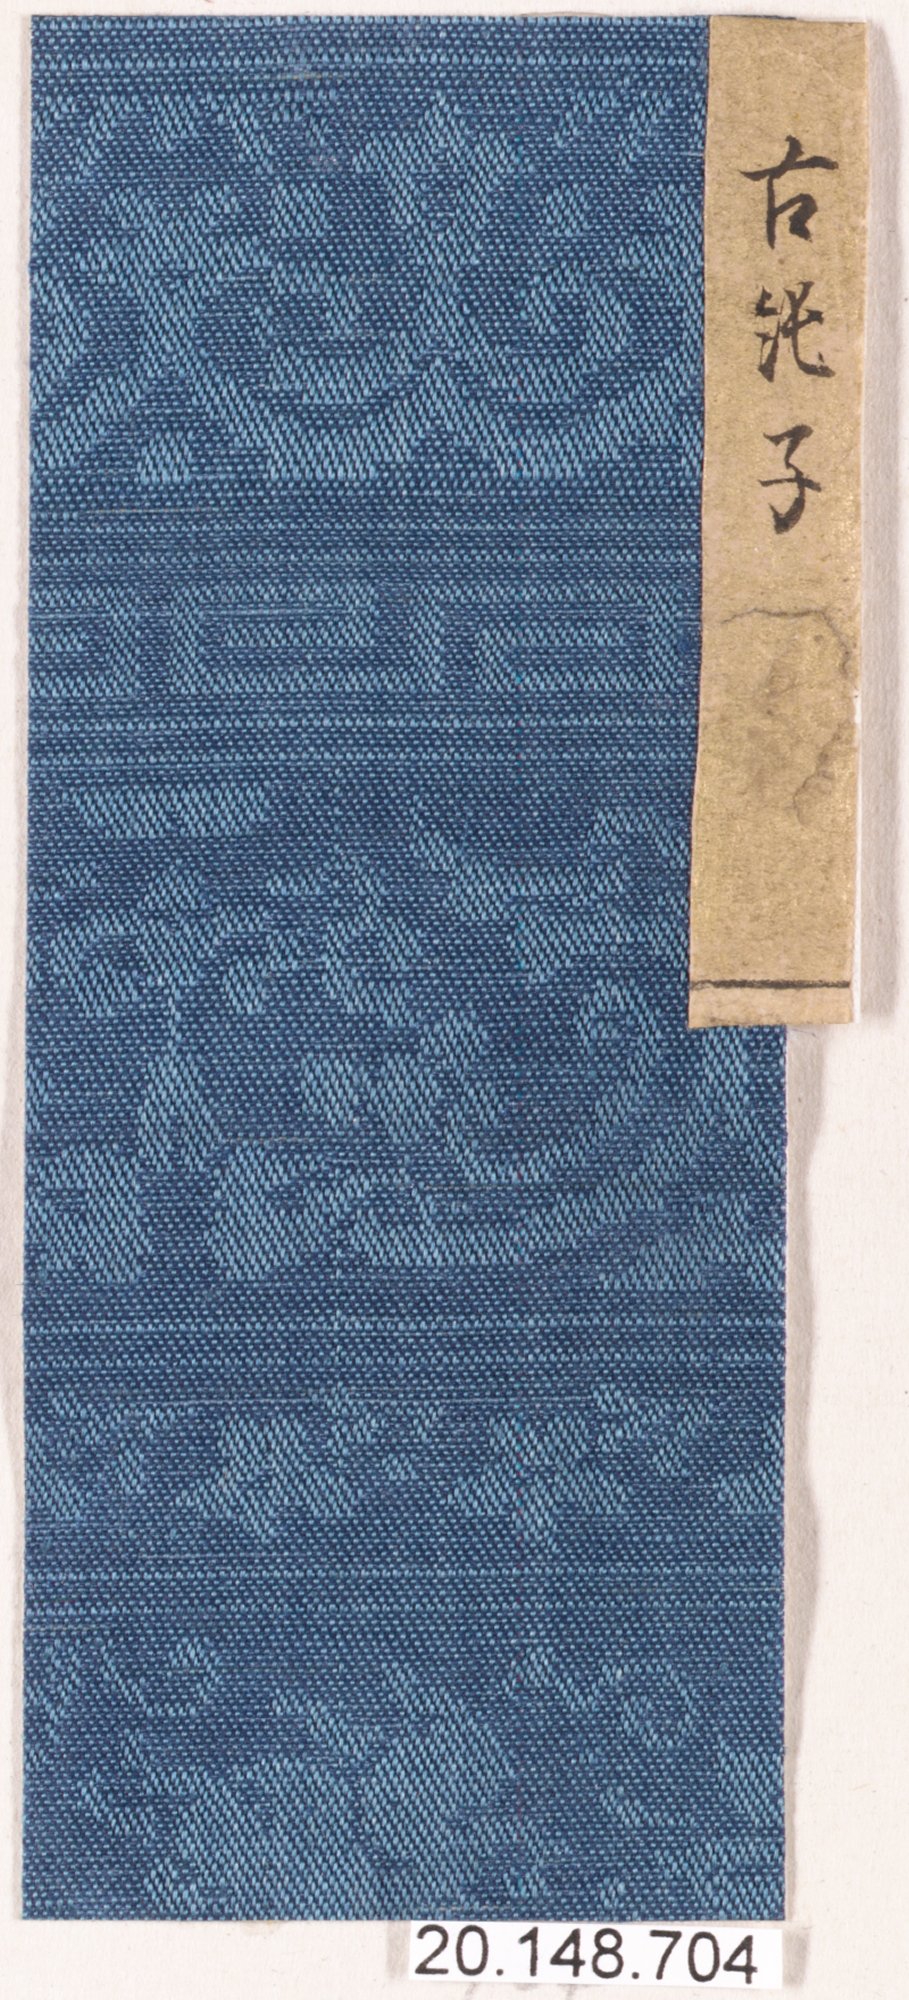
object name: piece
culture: japanese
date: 1701-1800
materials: silk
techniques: compound weave